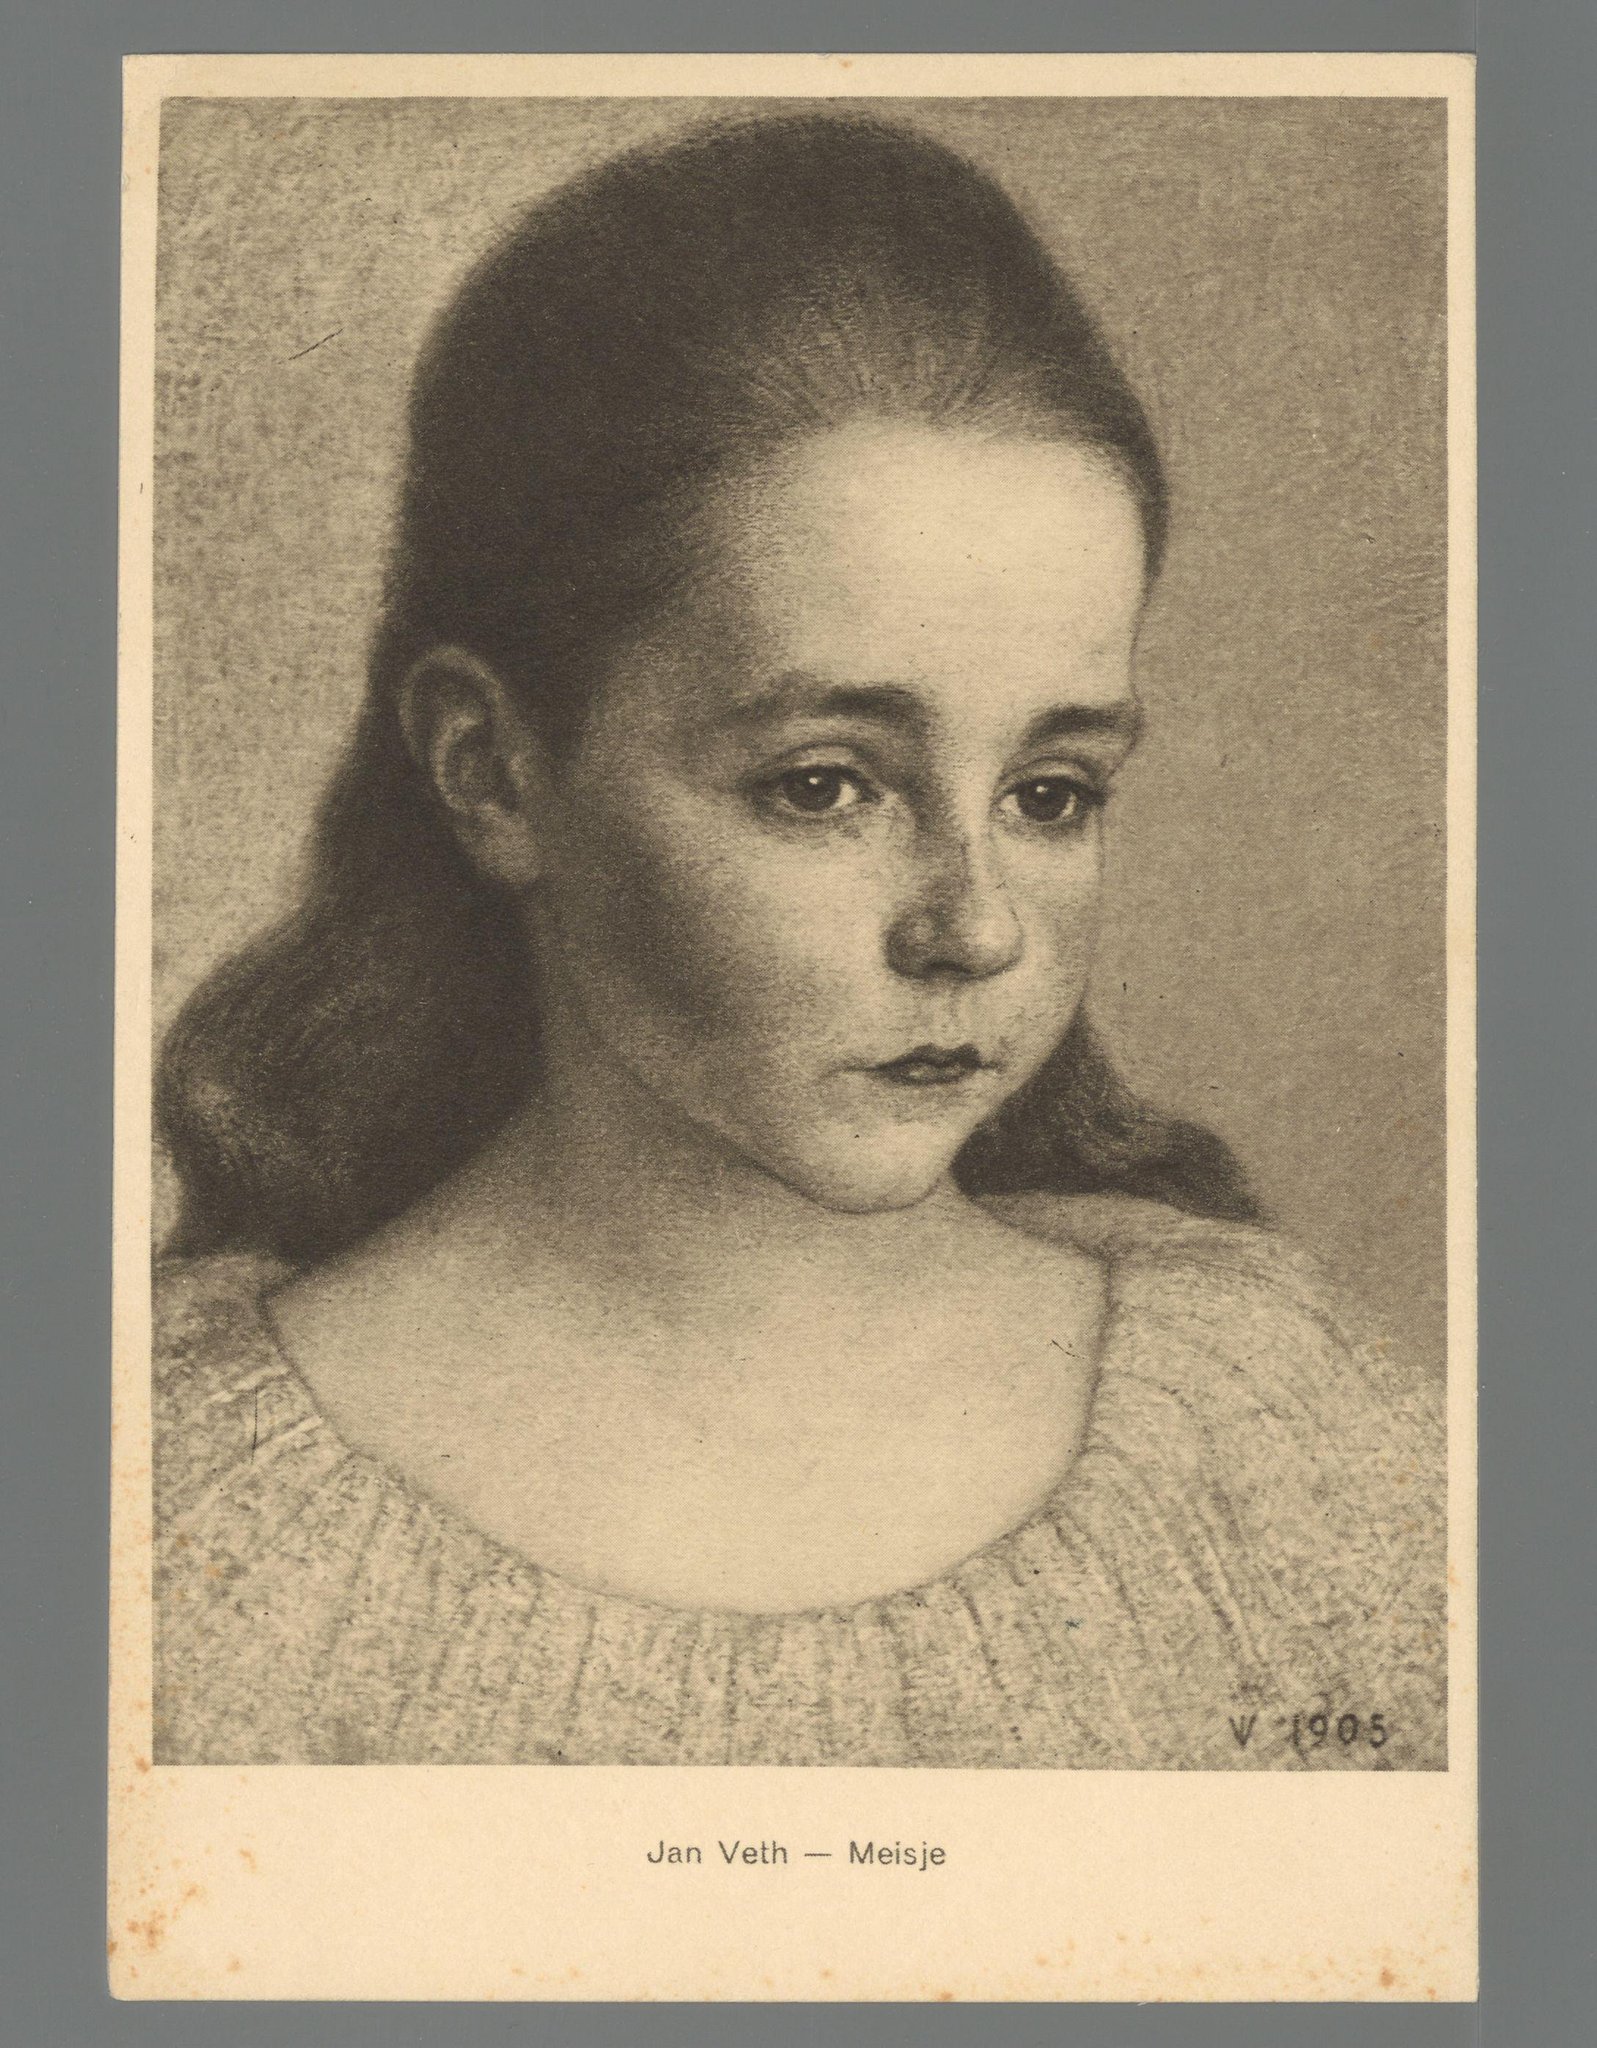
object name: ansichtkaart, prentbriefkaart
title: Jan Veth. Meisje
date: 1928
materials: cardboard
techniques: rotogravure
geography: amsterdam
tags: child, historical persons not known by name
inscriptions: collector's mark: ‘AFE v S’